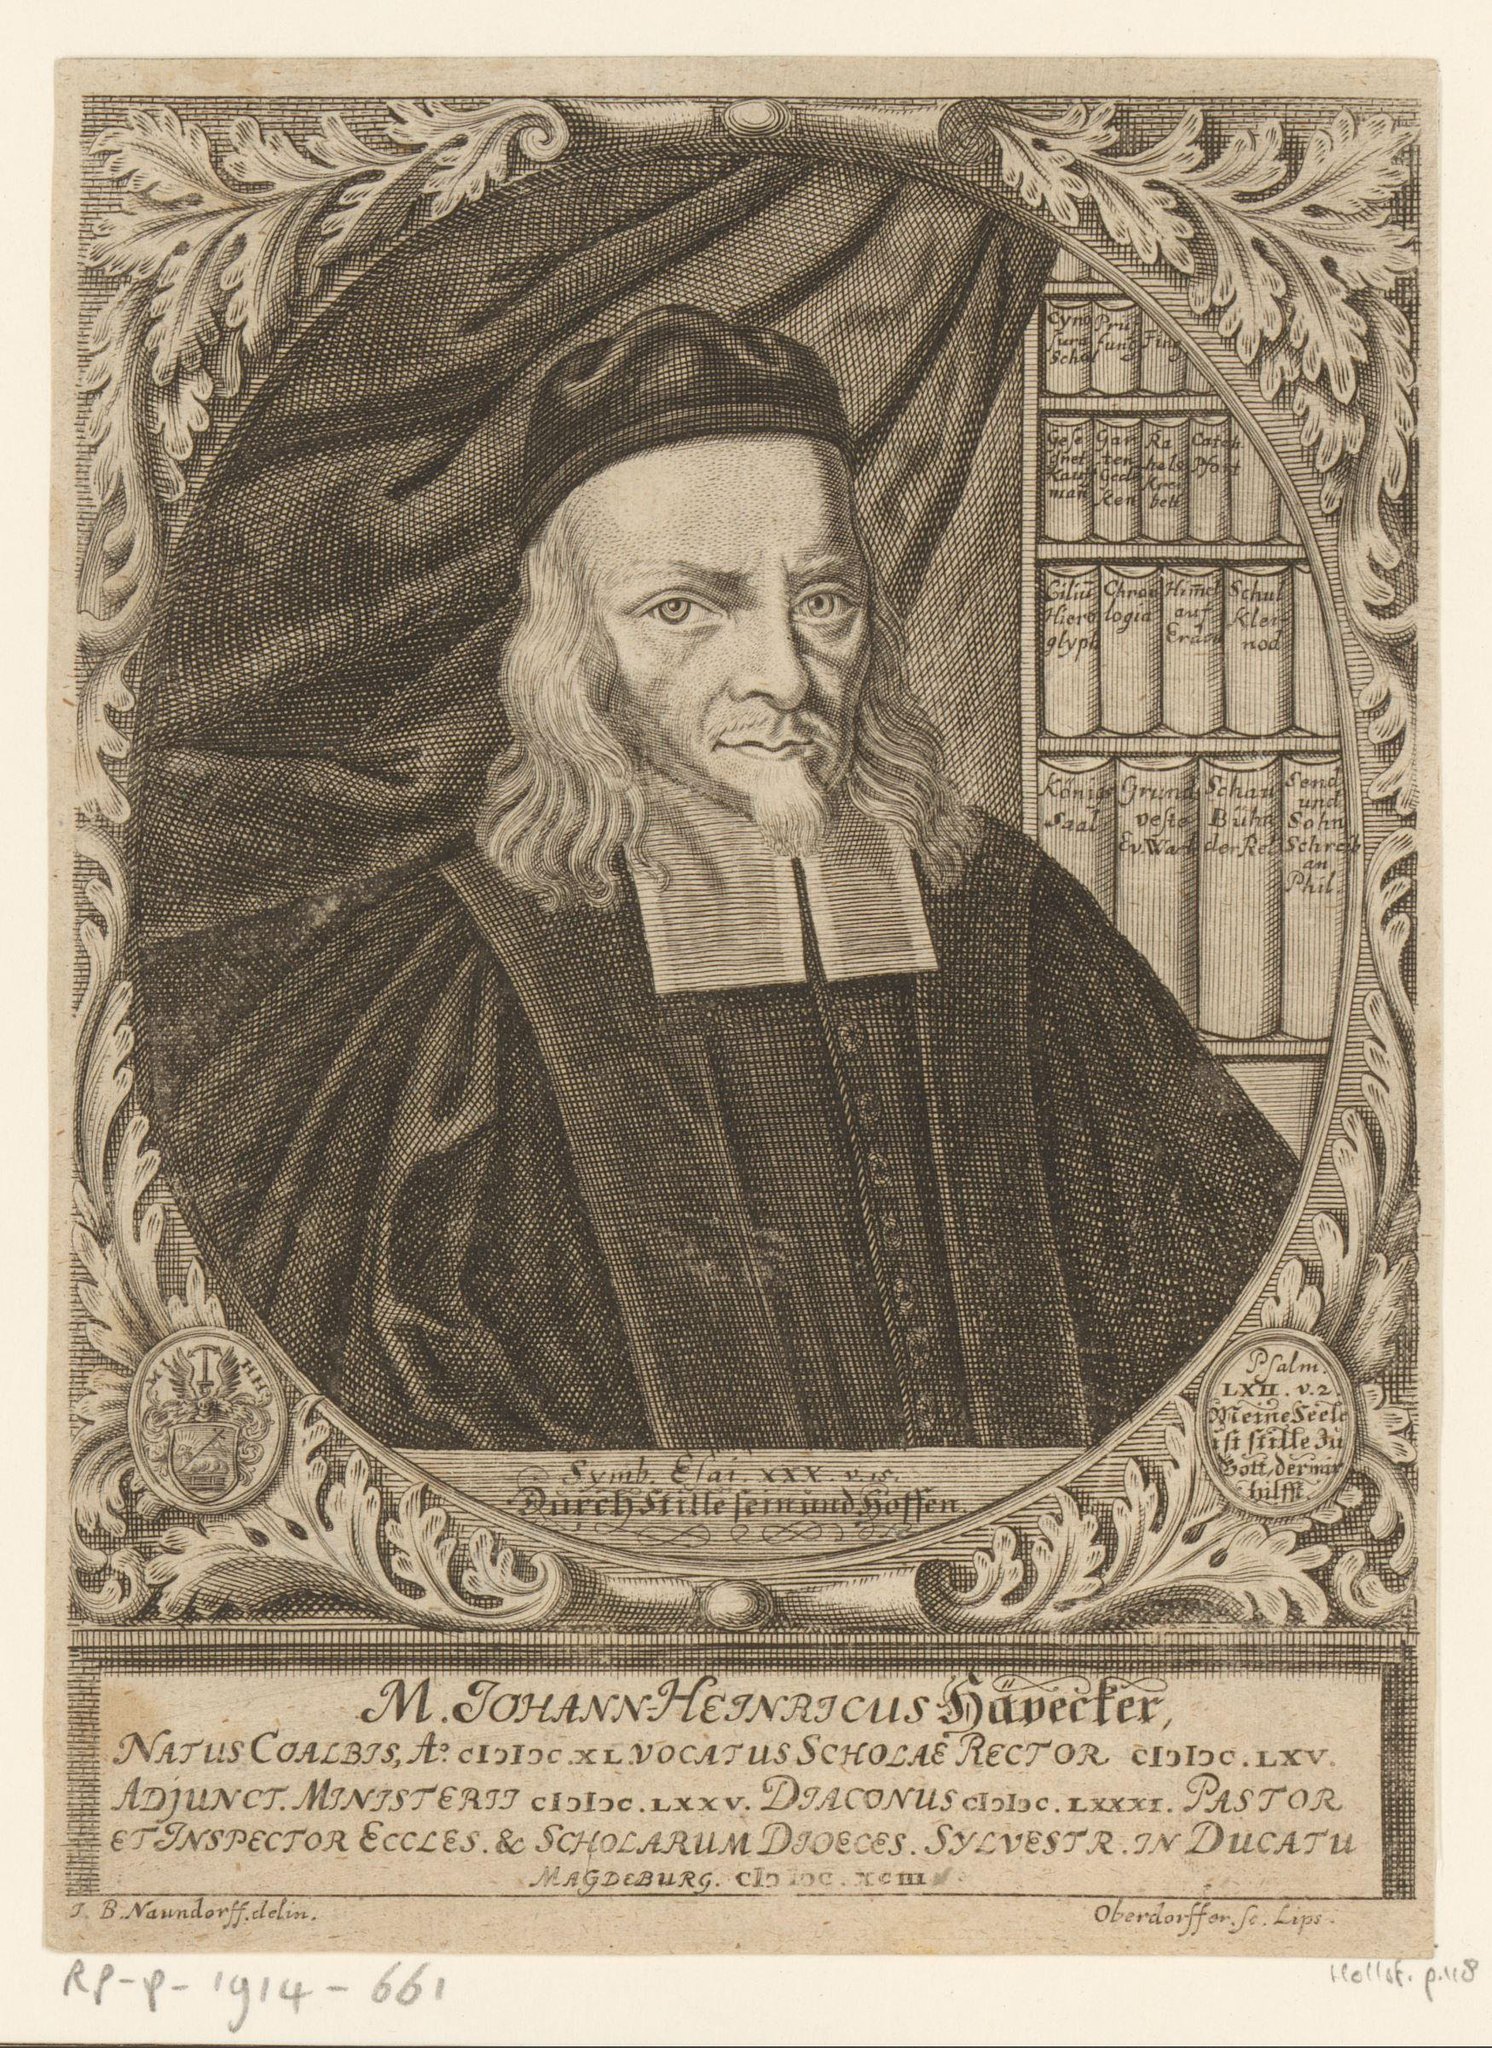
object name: print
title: Portret van Johann Heinrich Hävecker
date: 1693-1724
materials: paper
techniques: engraving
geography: leipzig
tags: bookshelves, historical persons, armorial bearing, heraldry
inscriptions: collector's mark: Lugt 2228